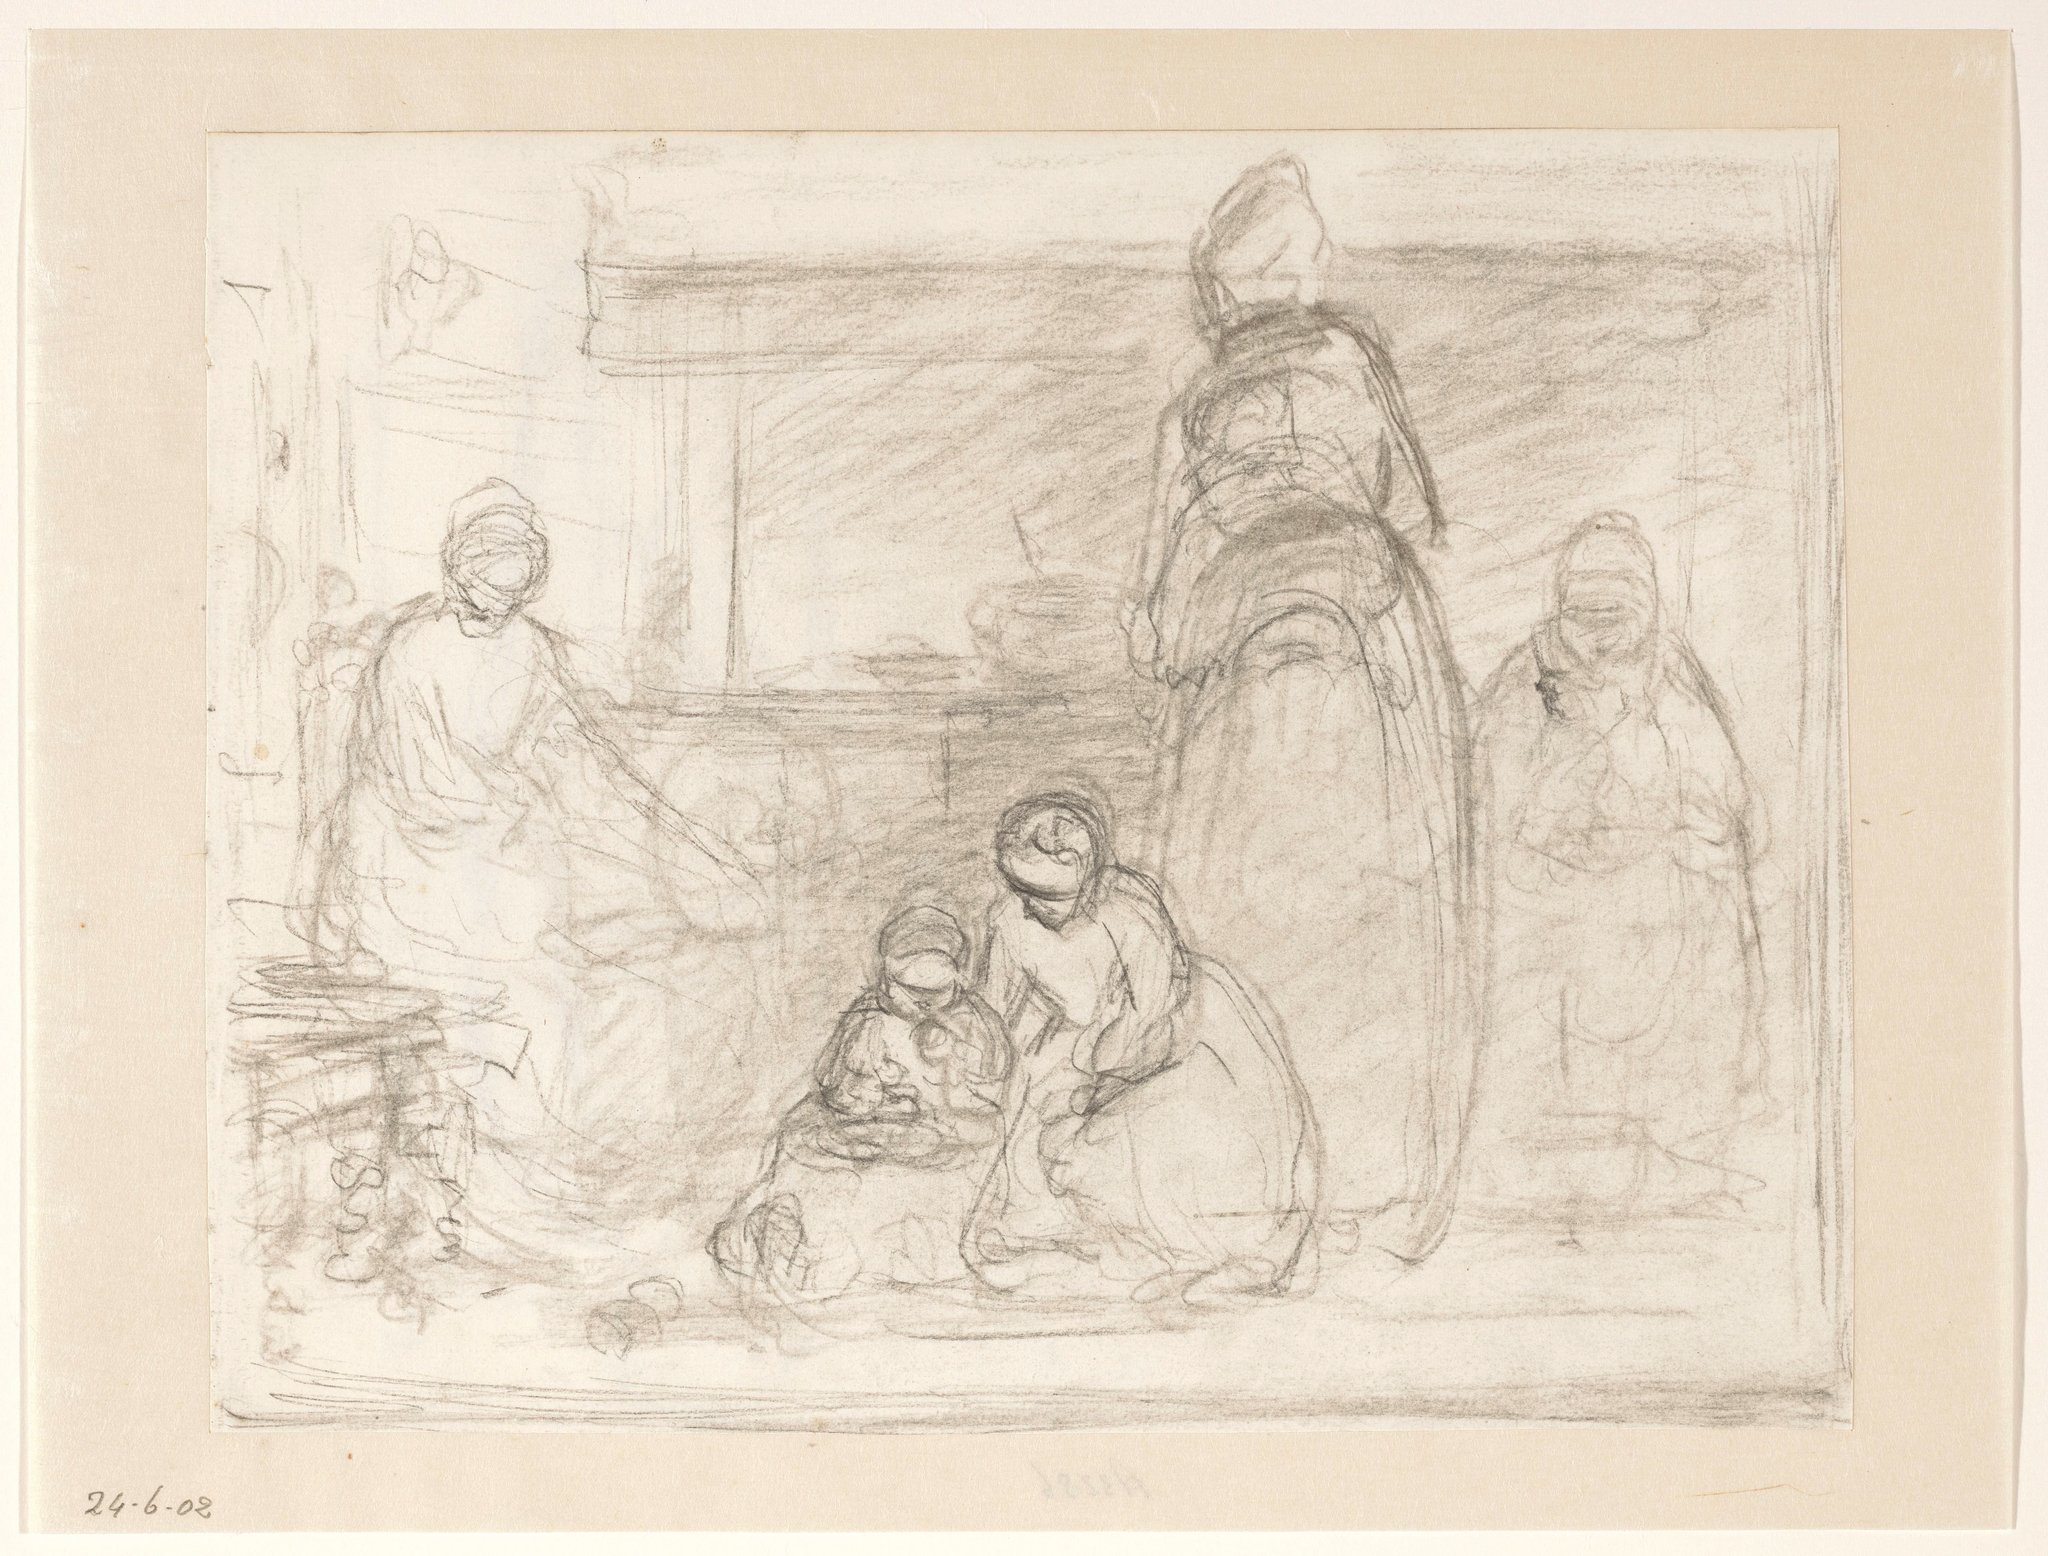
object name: drawing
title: Keukeninterieur met vrouwen en kinderen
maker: hendrik valkenburg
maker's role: draughtsman, painter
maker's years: 1826-1896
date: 1836-1896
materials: chalk, paper, pencil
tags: kitchen-interior, interior of the house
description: Keukeninterieur met vrouwen en kinderen. Verso: jongen op een stoel met een breedgerande hoed op schoot.